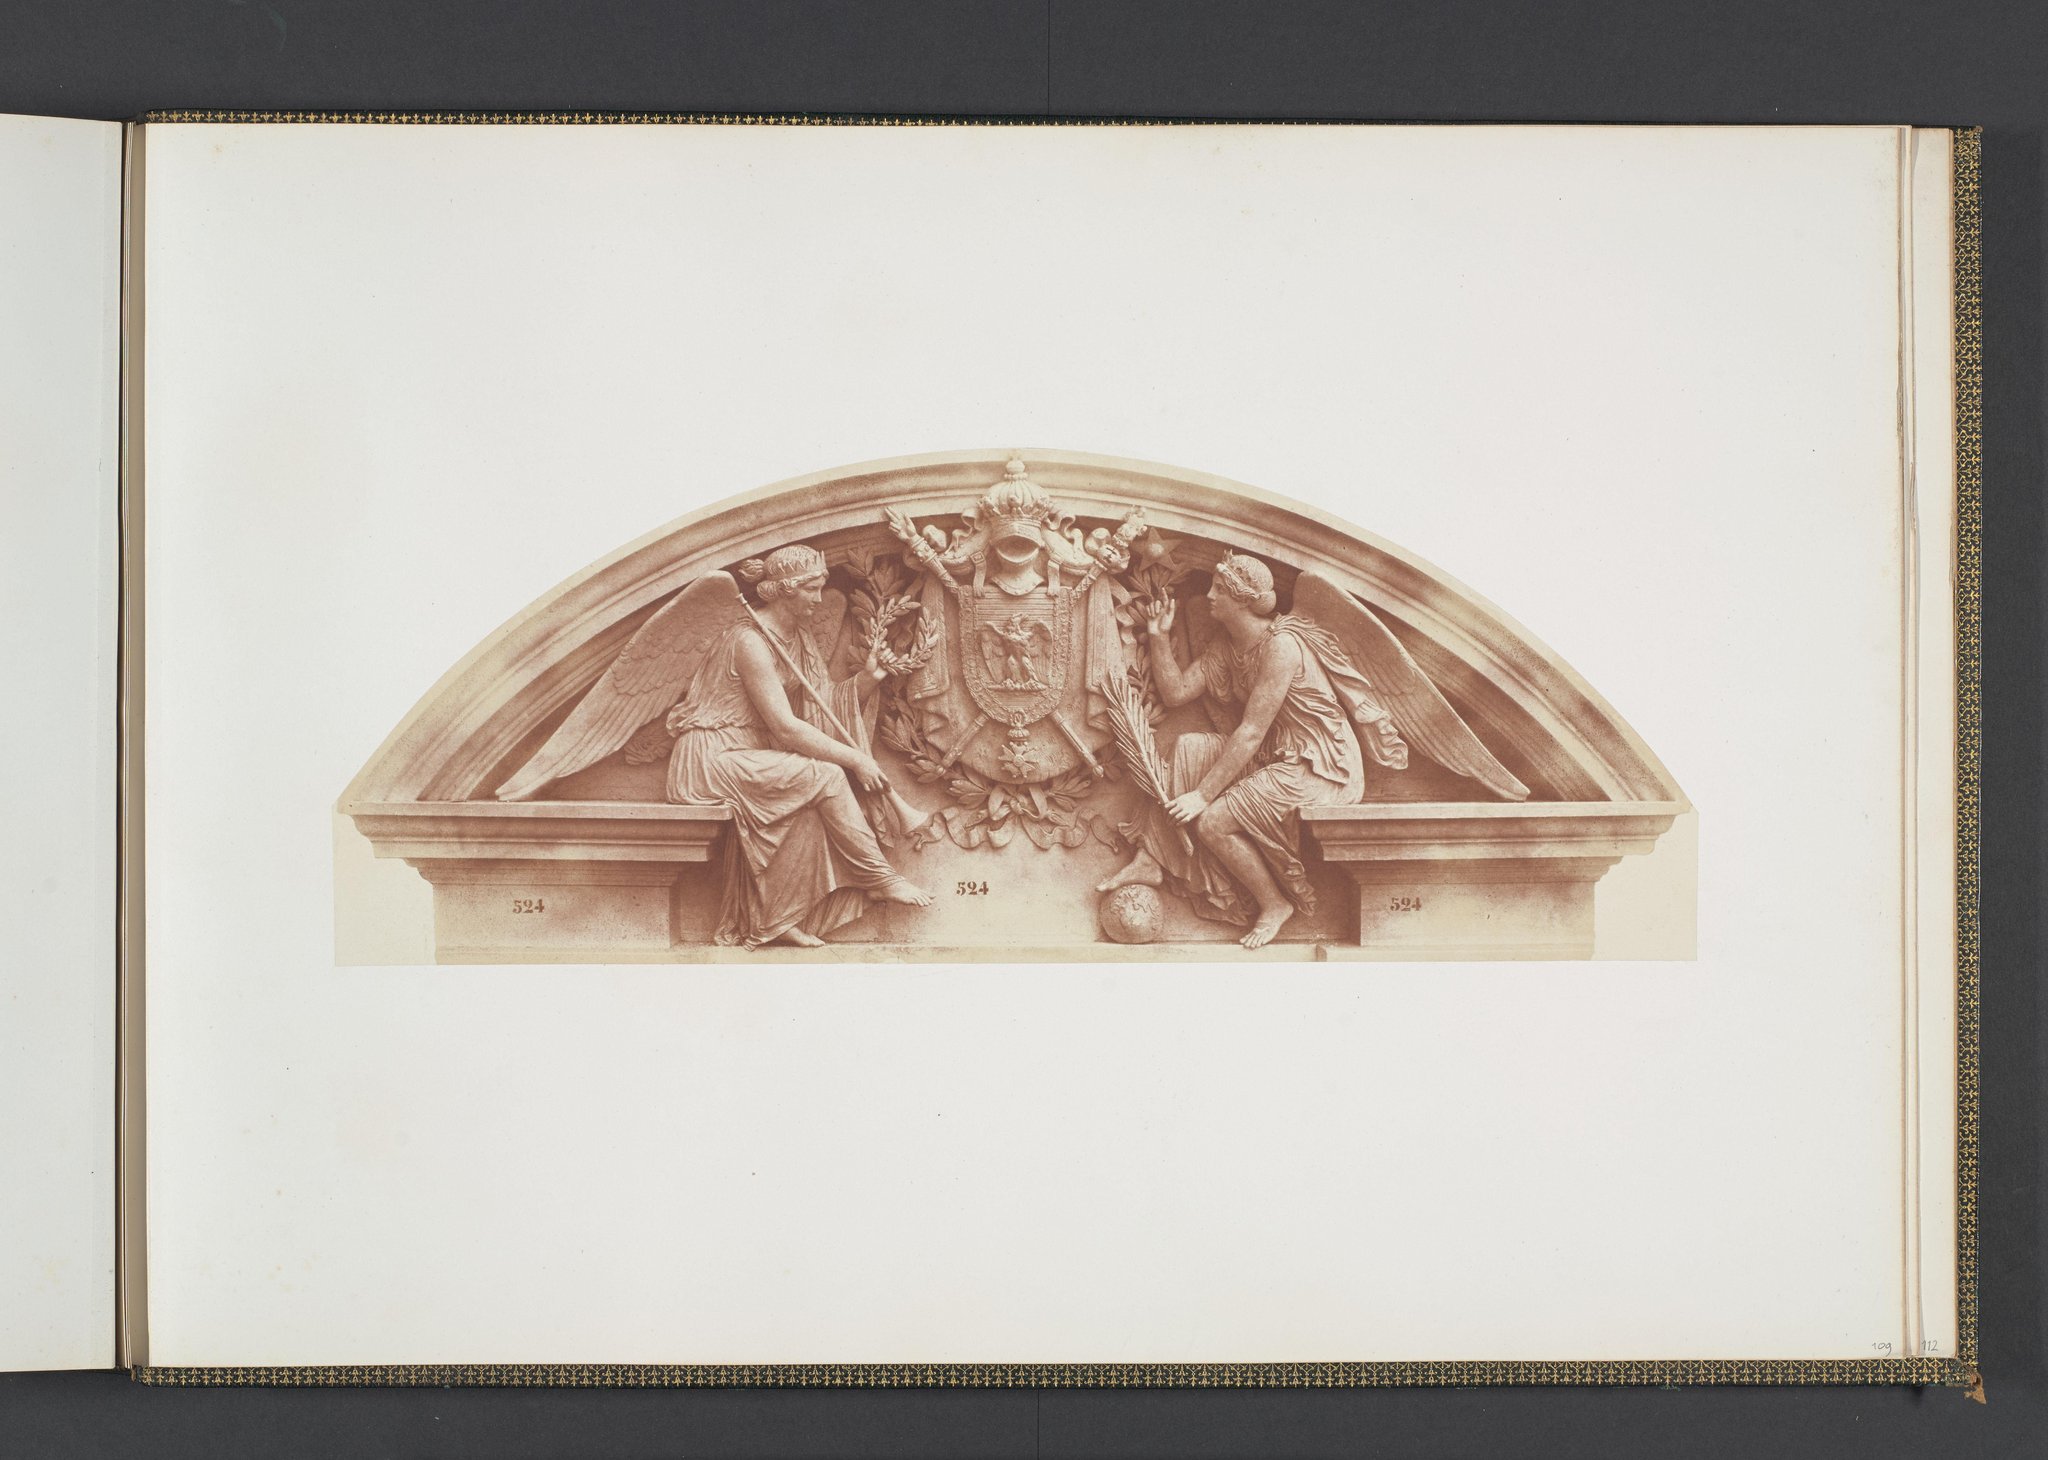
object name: photograph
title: Gipsmodel voor beeldhouwwerk op het Palais du Louvre: "La Gloire et l'Immortalité" door Augustin Alexandre Dumont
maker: édouard denis baldus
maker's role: fotograaf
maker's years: 1813-1889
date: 1855-1857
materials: paper, photographic support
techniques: salted paper print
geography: paris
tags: piece of sculpture, reproduction of a piece of sculpture, permanent exhibition, museum, paris, tuileries palace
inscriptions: number: ‘524’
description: Onderdeel van Réunion des Tuileries au Louvre 1852-1857, album 2.